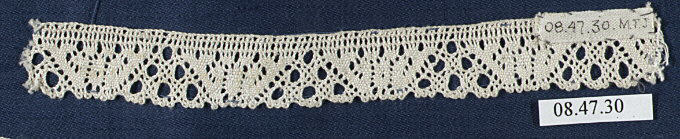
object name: fragment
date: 1801-1900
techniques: lace